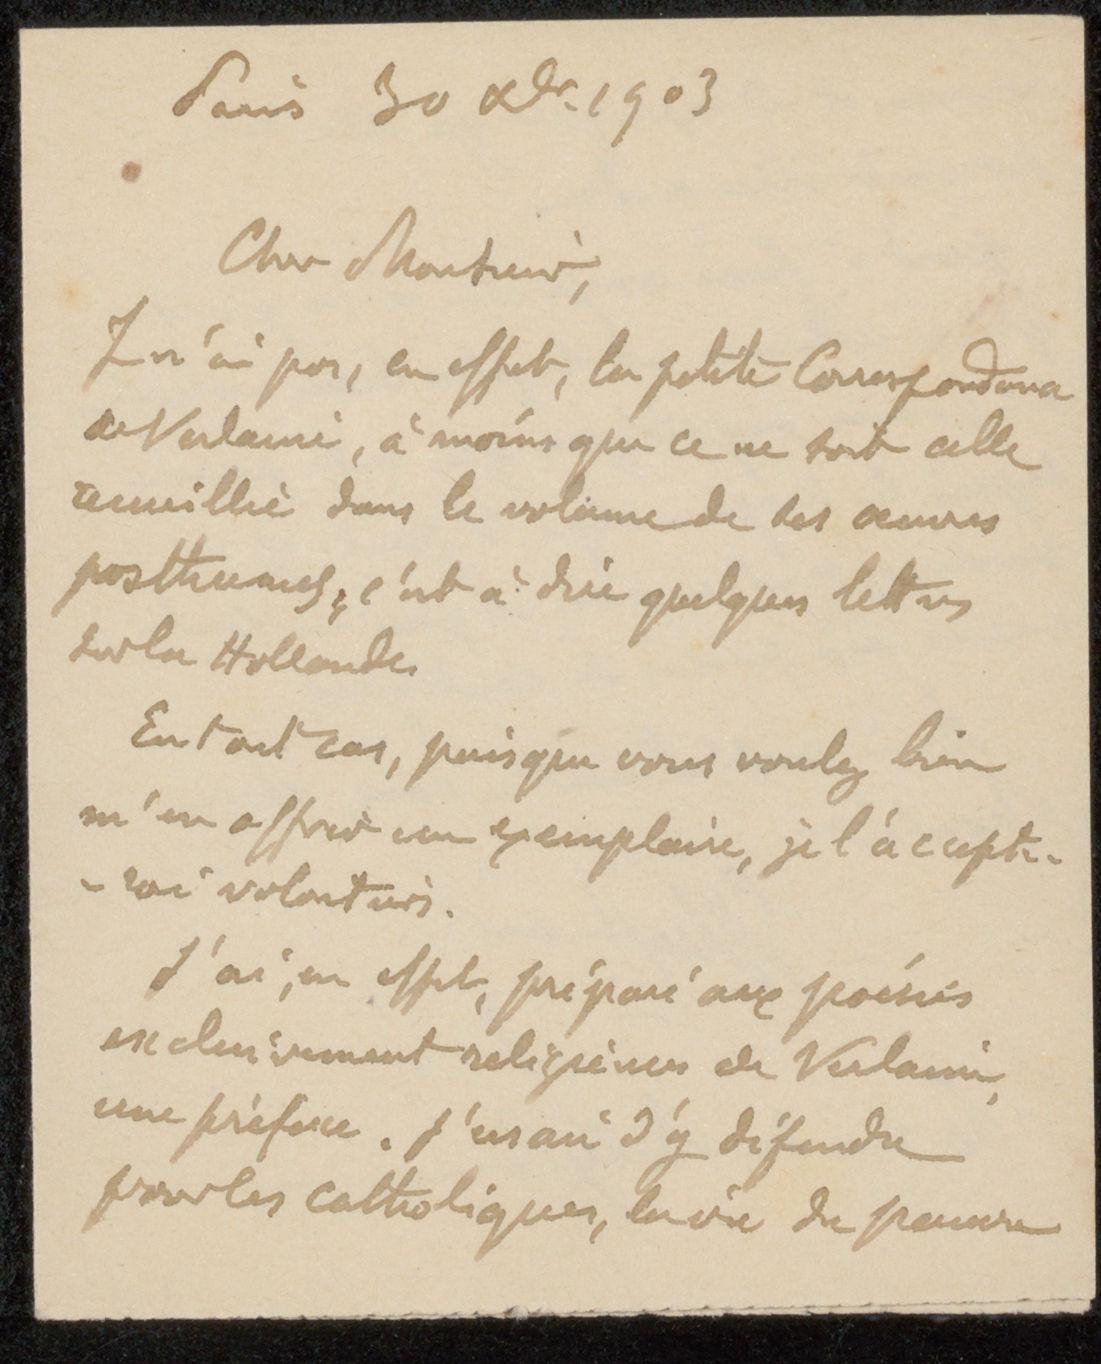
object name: letter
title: Brief aan Philip Zilcken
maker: joris-karl huysmans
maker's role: schrijver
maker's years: 1848-1907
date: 1903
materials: ink, paper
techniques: pen, writing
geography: paris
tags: paul verlaine, painter, draughtsman, philip zilcken, literature ~ arts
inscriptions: collector's mark: ‘RPK’